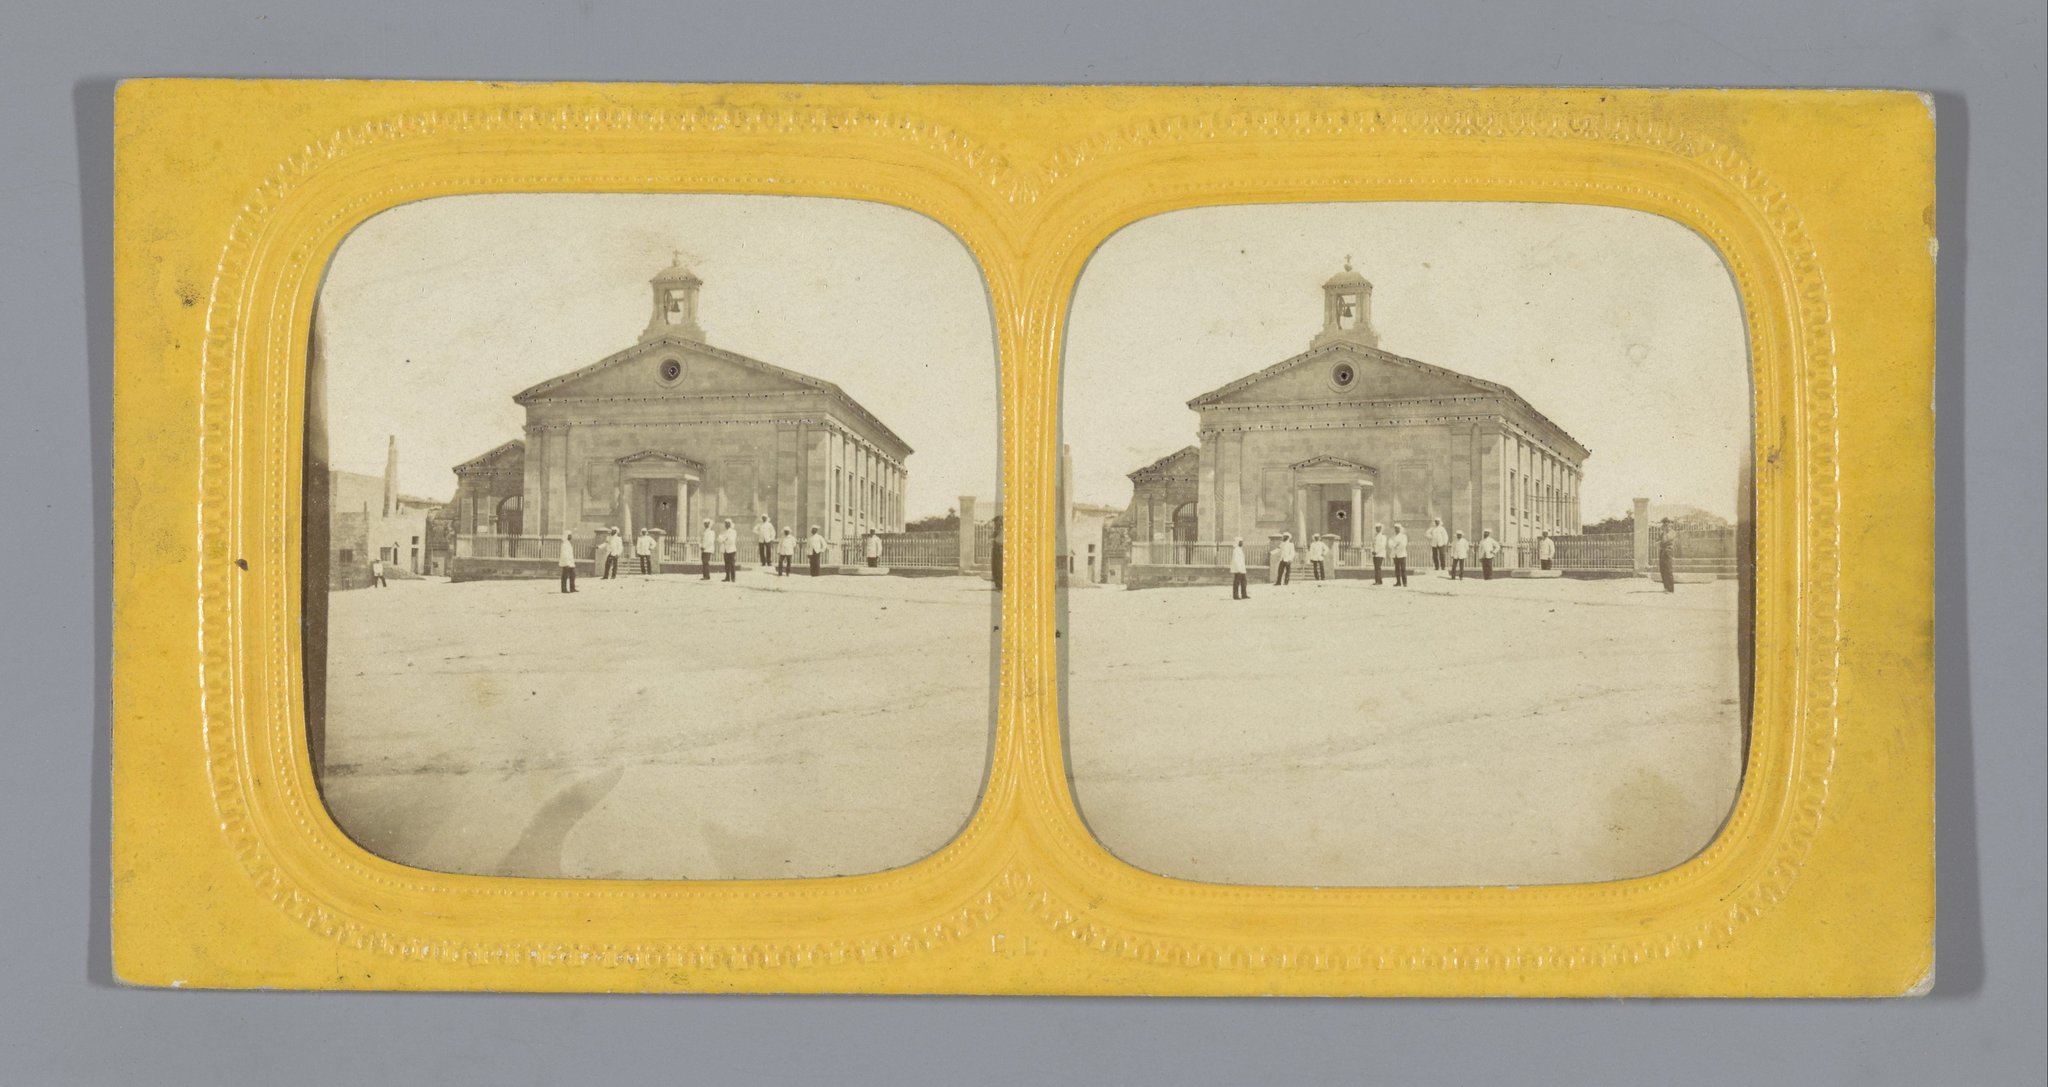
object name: tissue stereograph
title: Veduta della Chiesa Inglese, Valletta, Malta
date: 1855-1875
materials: cardboard, paper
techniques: albumen print, hand coloring, perforating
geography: paris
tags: church (exterior)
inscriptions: number: ‘40’